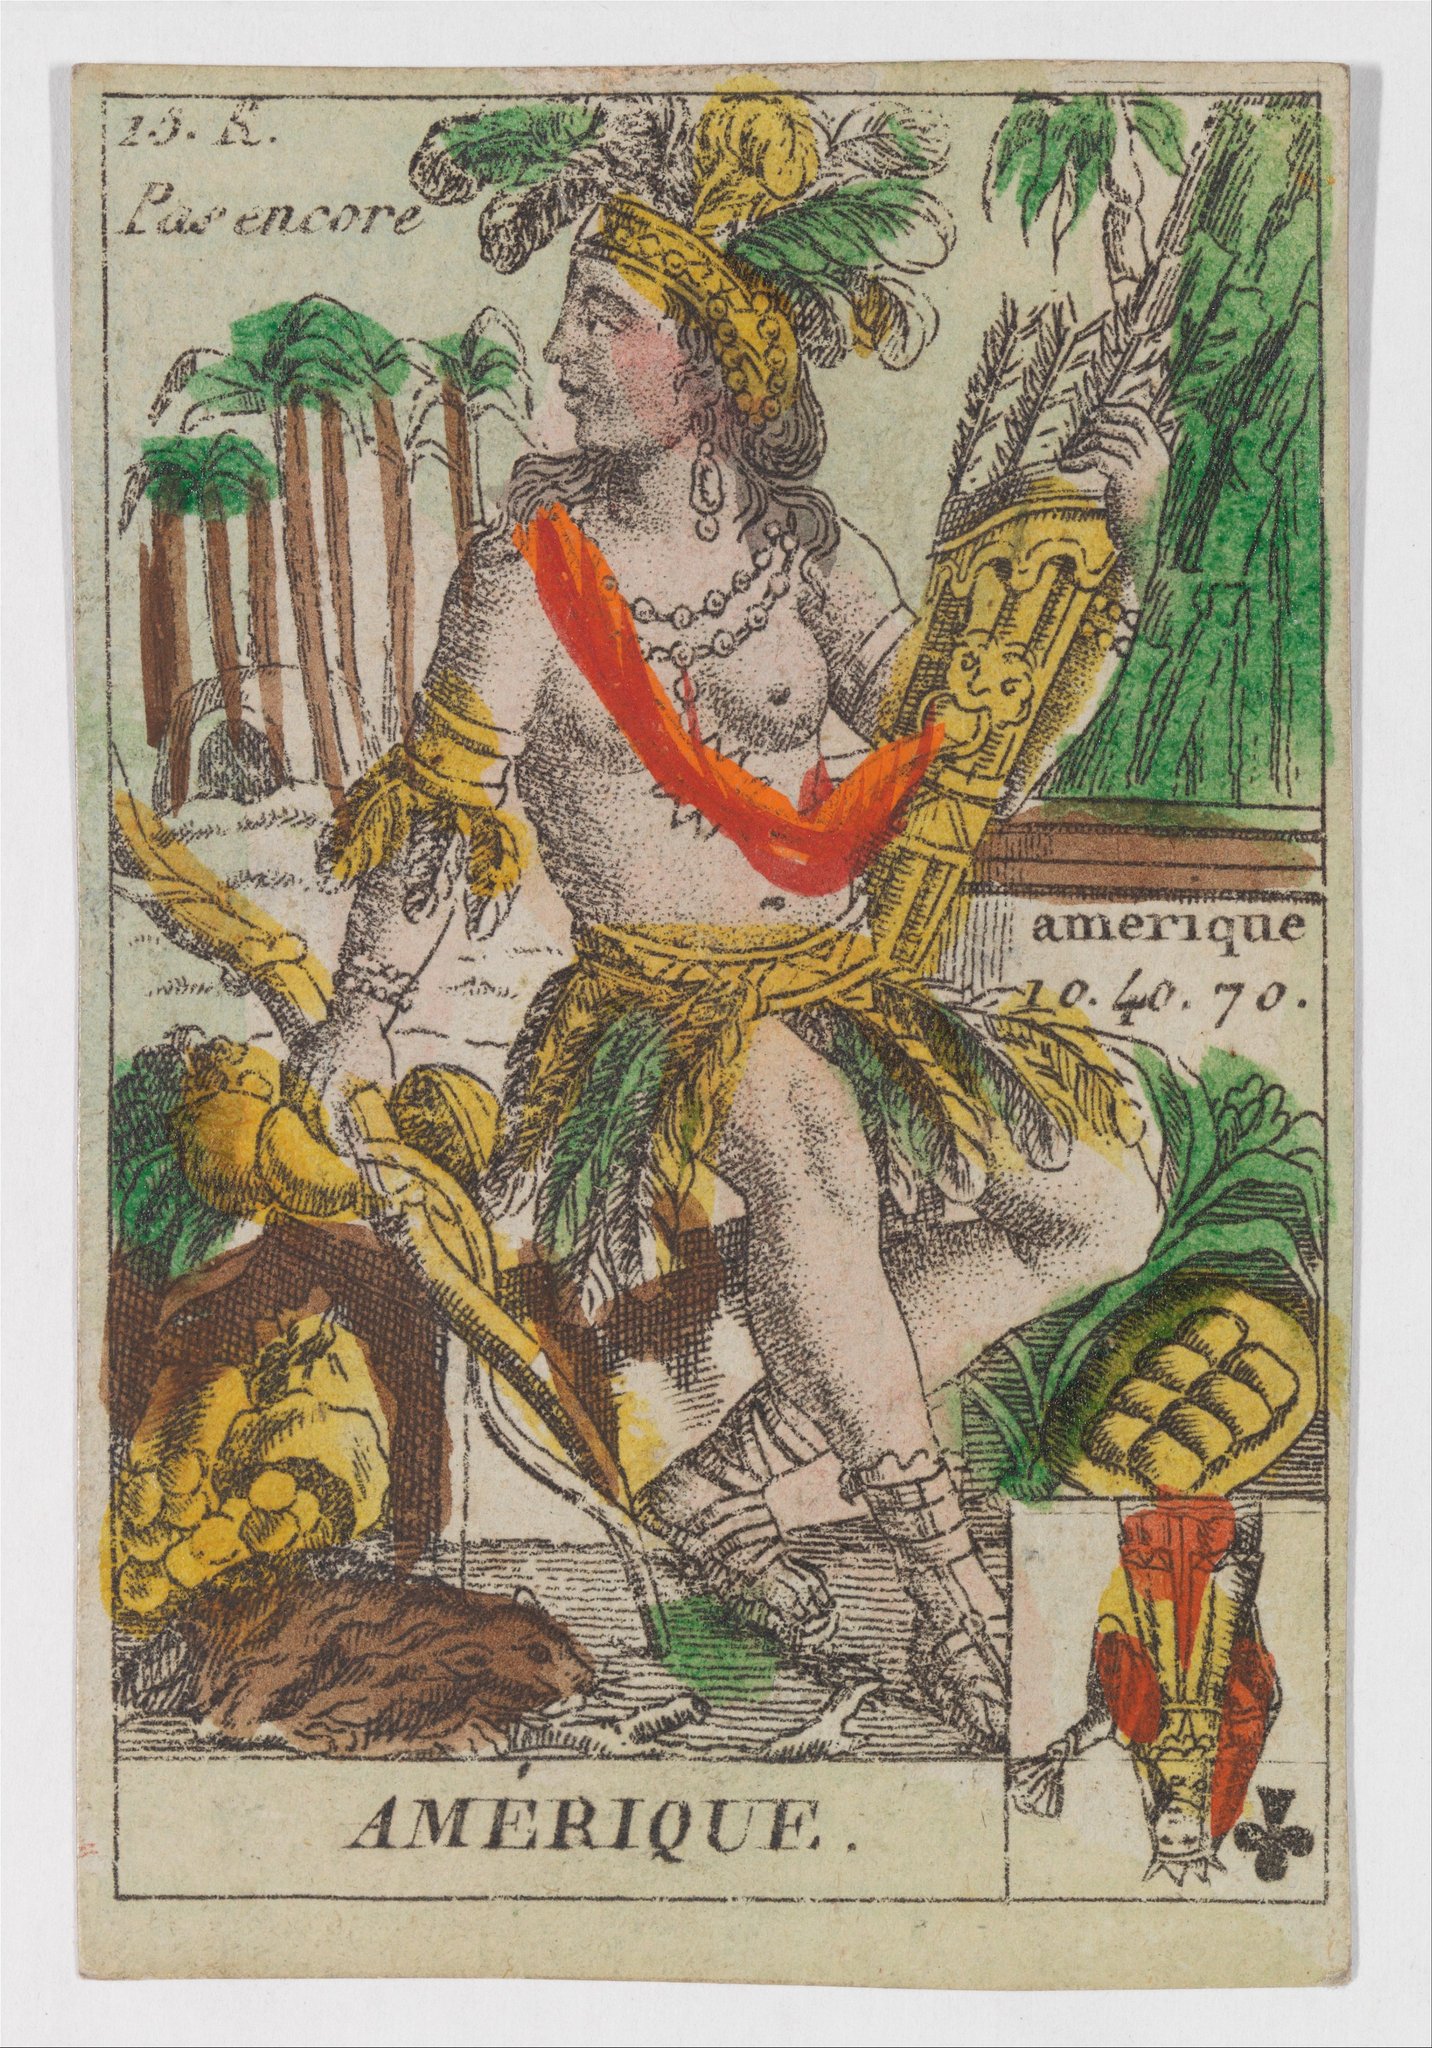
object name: print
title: Amerique, from the playing cards (for quartets) "Costumes des Peuples Étrangers"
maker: anonymous, french, 18th century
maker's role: artist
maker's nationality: french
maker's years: 1700-1800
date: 1700-1799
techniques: etching, hand coloring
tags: bow and arrow,female nudes,playing cards